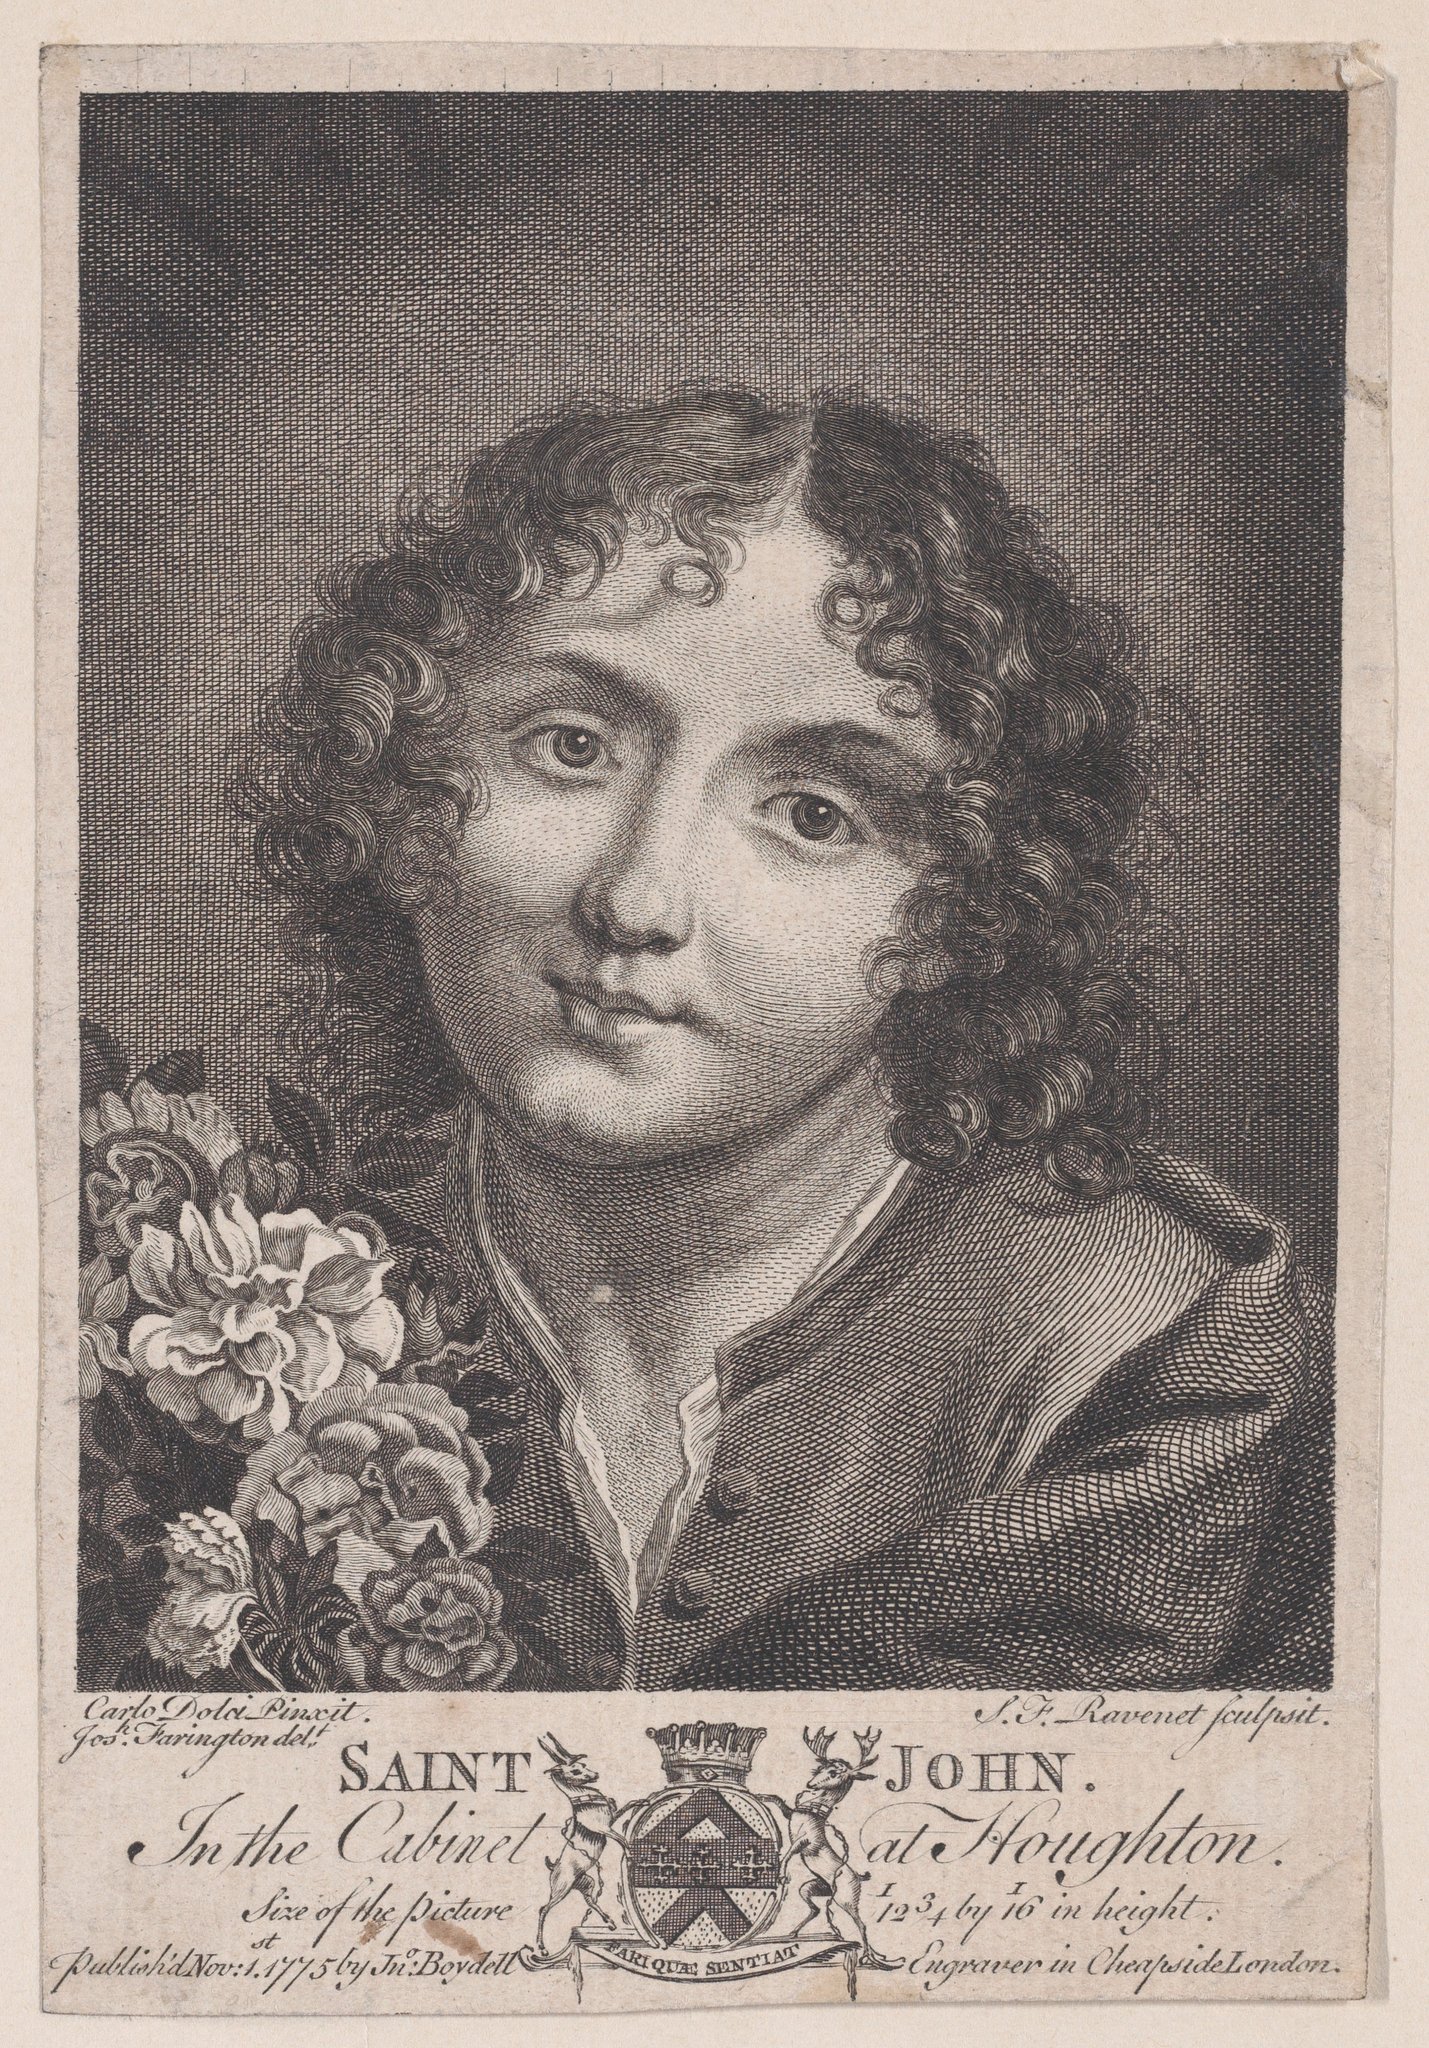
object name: print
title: Saint John the Baptist with flowers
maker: simon-françois ravenet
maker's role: artist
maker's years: 1748-1814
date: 1775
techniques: engraving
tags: men,saint john the baptist